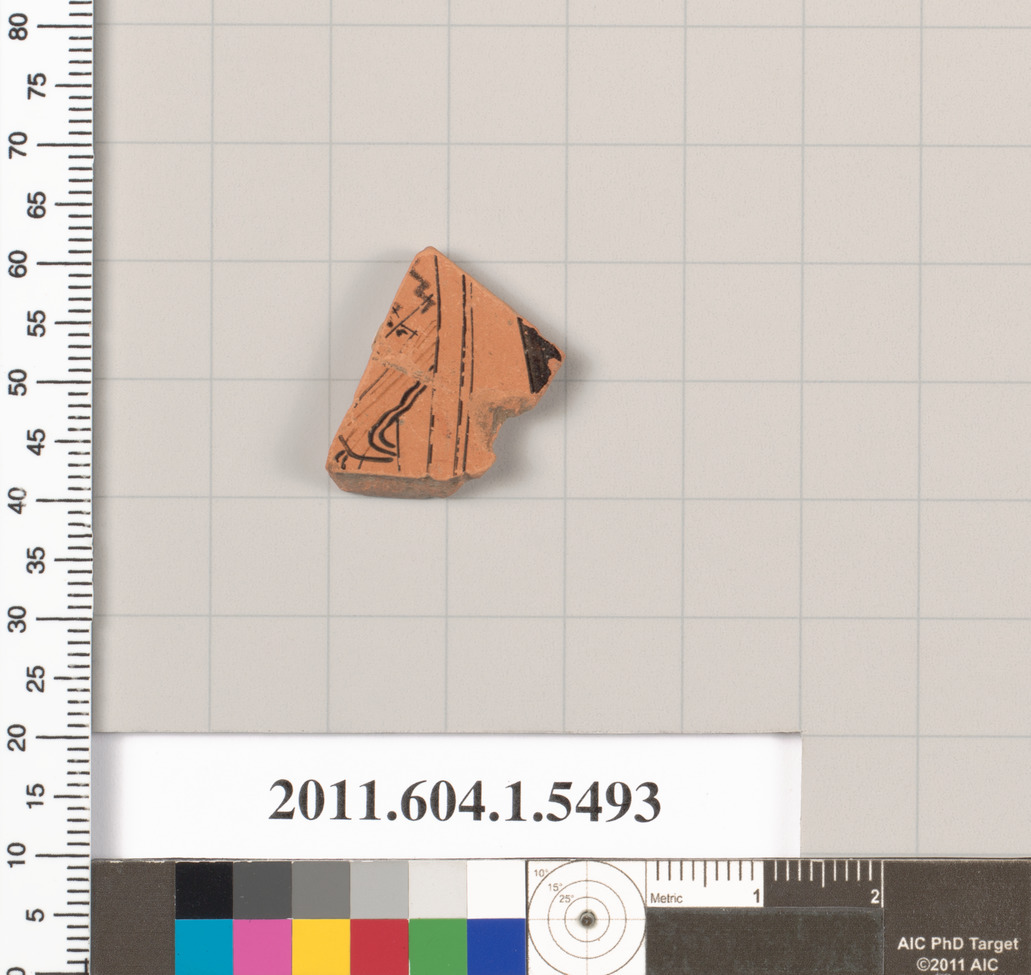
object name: kylix fragment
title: Terracotta fragment of a kylix (drinking cup)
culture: greek, attic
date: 500-480 BCE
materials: terracotta